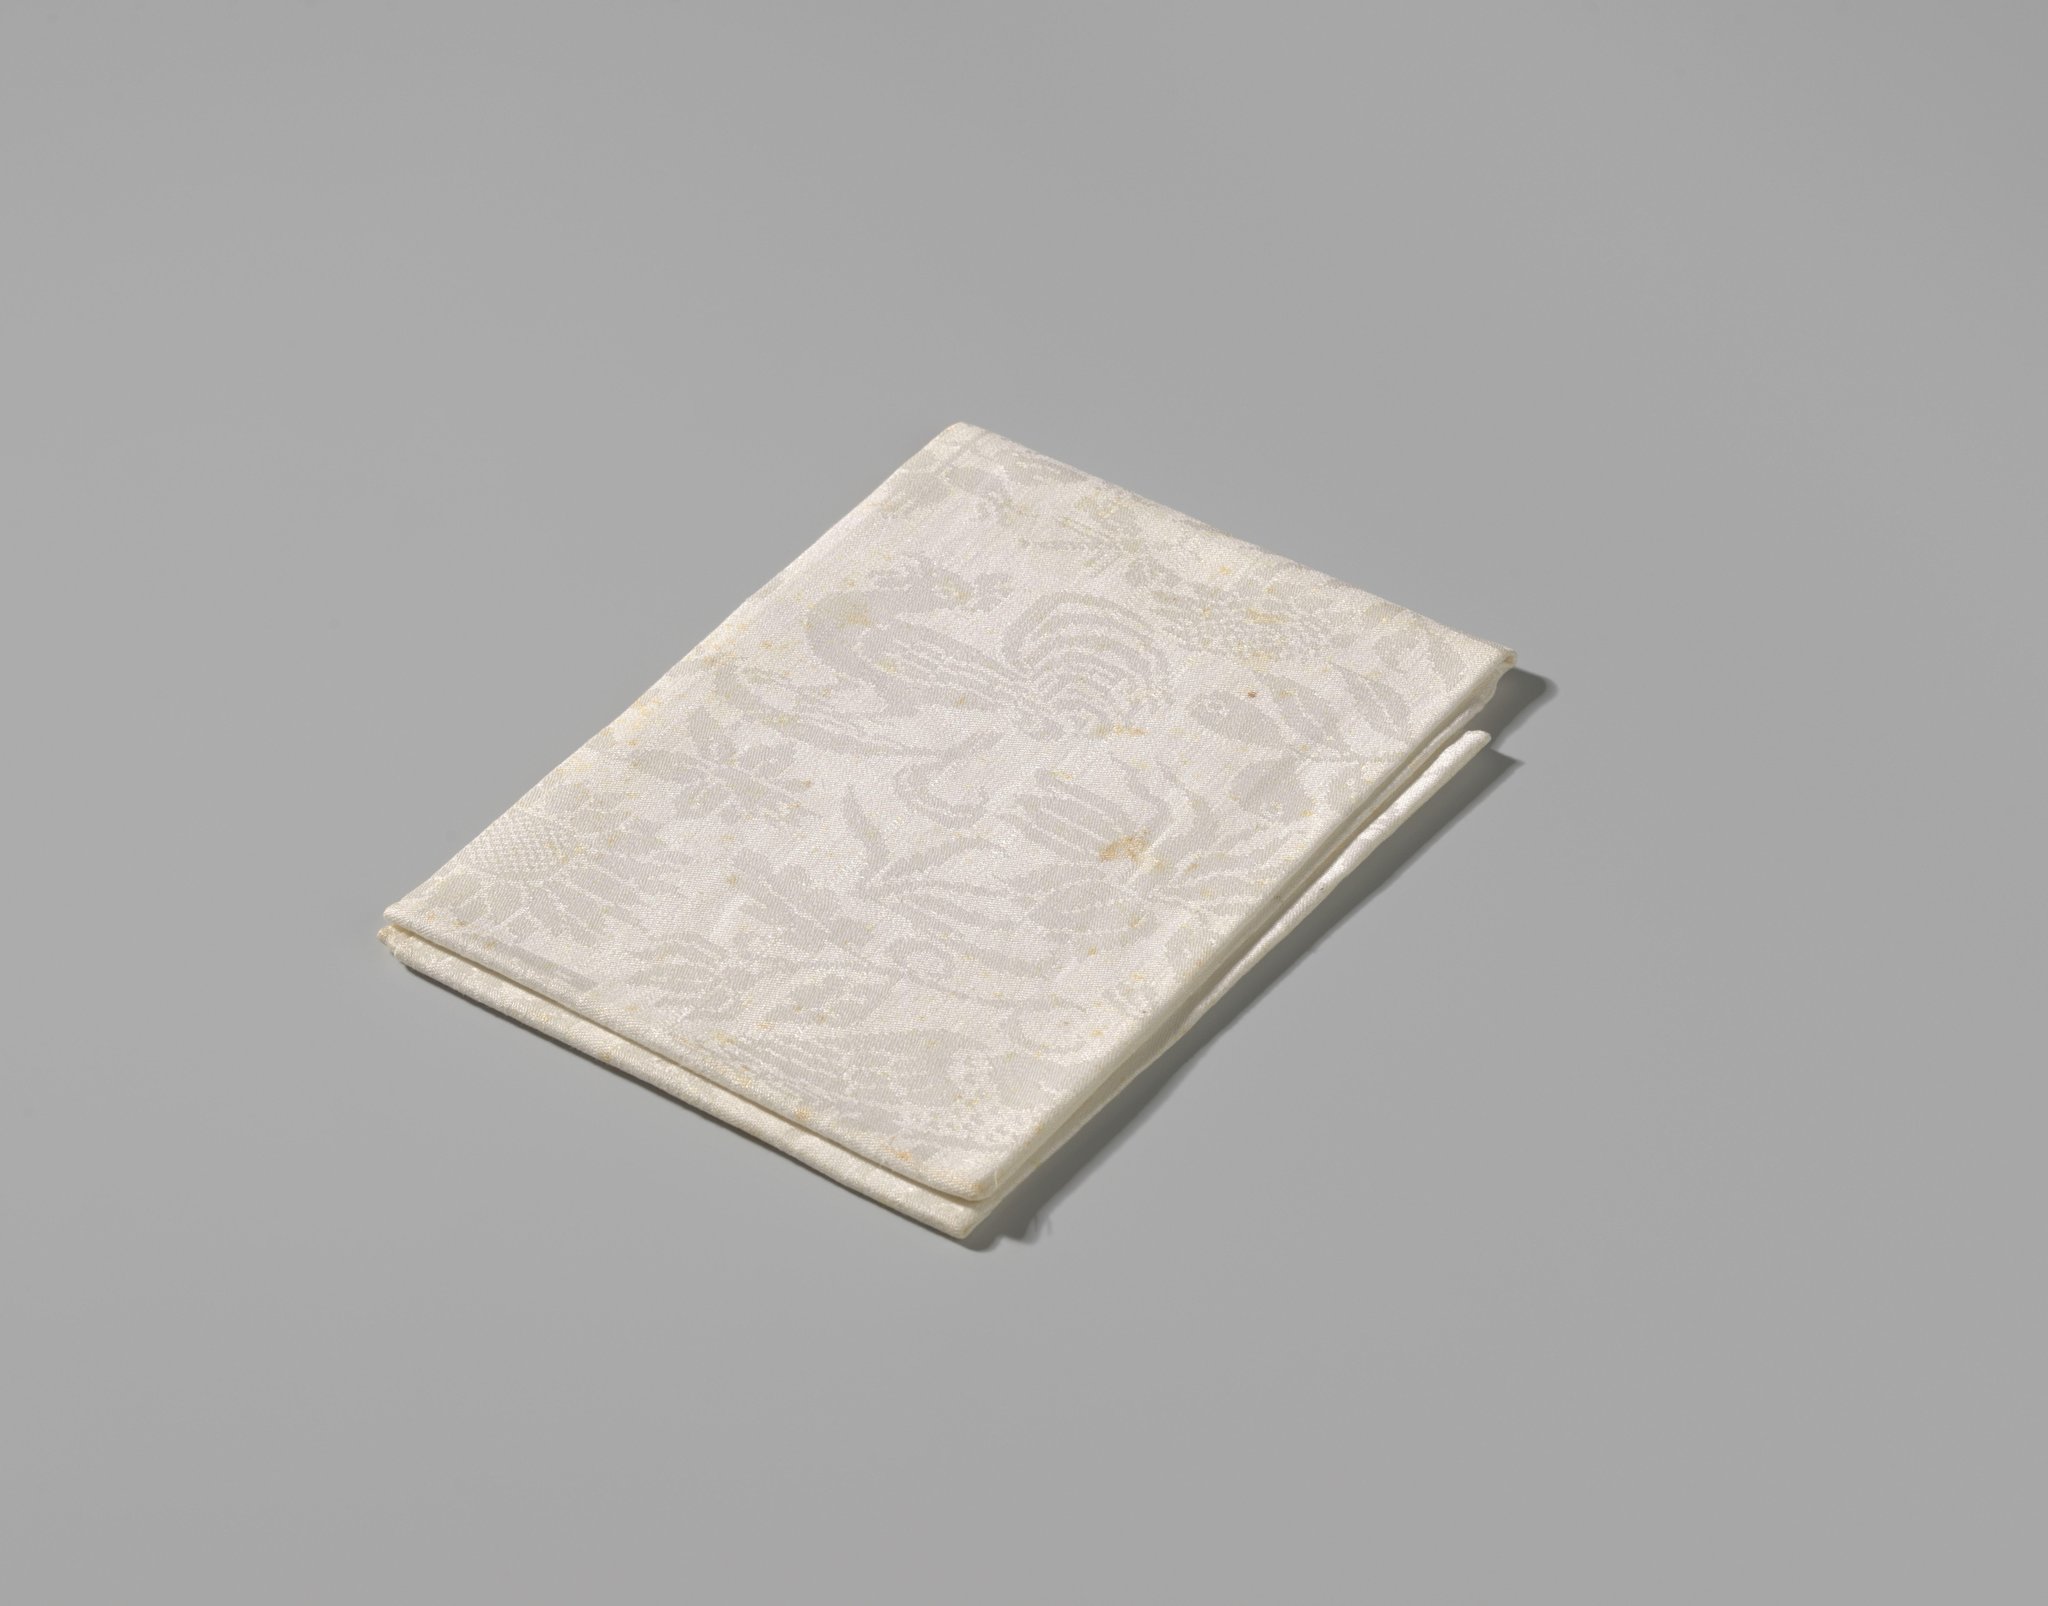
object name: napkin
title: Servet van linnendamast met een bloempatroon.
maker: Anonymous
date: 1625-1650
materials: linen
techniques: damask, weave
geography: flanders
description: Servet van linnendamast met gestrooide bloemen, vruchten en vruchten pikkende vogels. Het servet is gemerkt: MI E 6 en een teken (liggende K?).